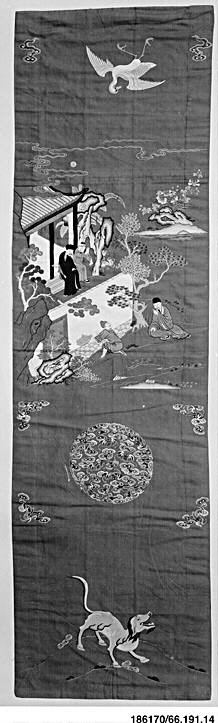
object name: chair strip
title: One of a Set of Twelve Chair Strips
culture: chinese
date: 1736-1795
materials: metal thread, silk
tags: cranes,men,dogs,pavilions